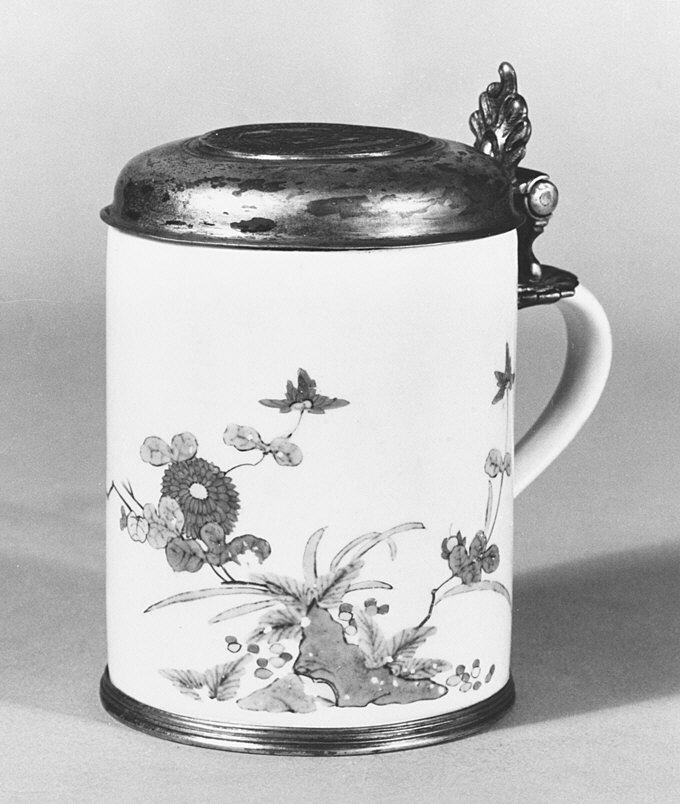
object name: tankard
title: Small tankard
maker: meissen manufactory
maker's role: manufactory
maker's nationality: german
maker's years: 1710-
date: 1730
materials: gilt silver, hard paste porcelain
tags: flowers